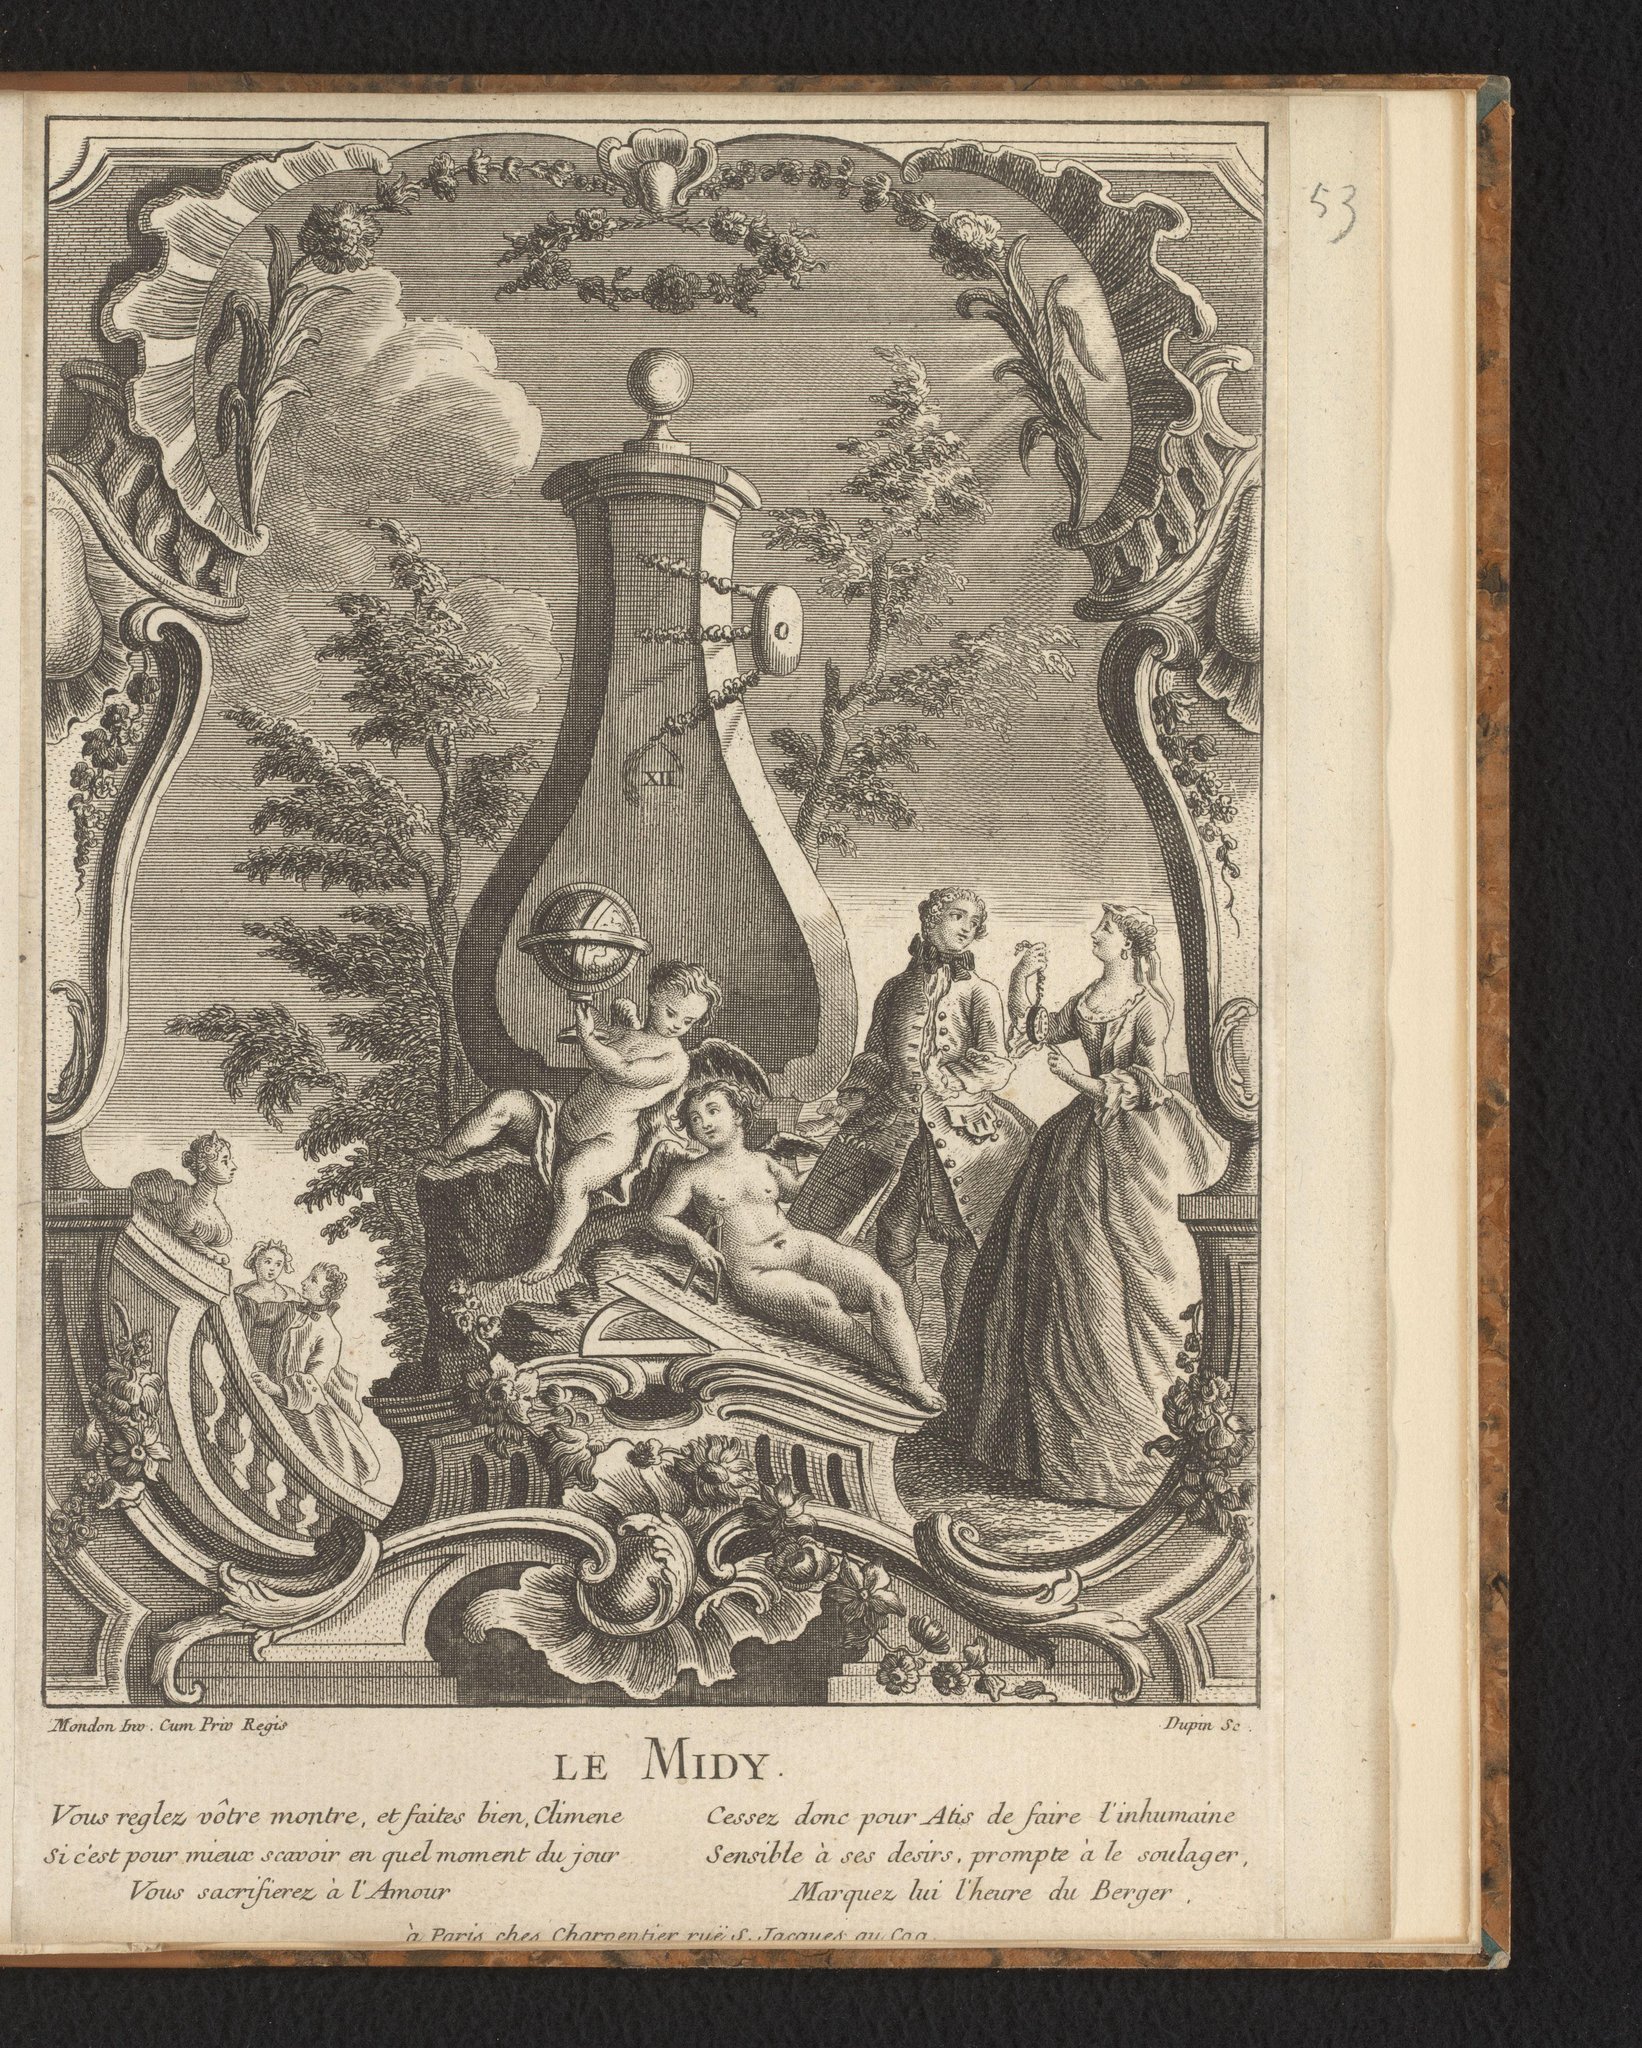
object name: album leaf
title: Le Midy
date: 1719-1751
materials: paper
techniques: engraving, etching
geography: france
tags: rocaille ornament, watch, cupids: 'amores', 'amoretti', 'putti'